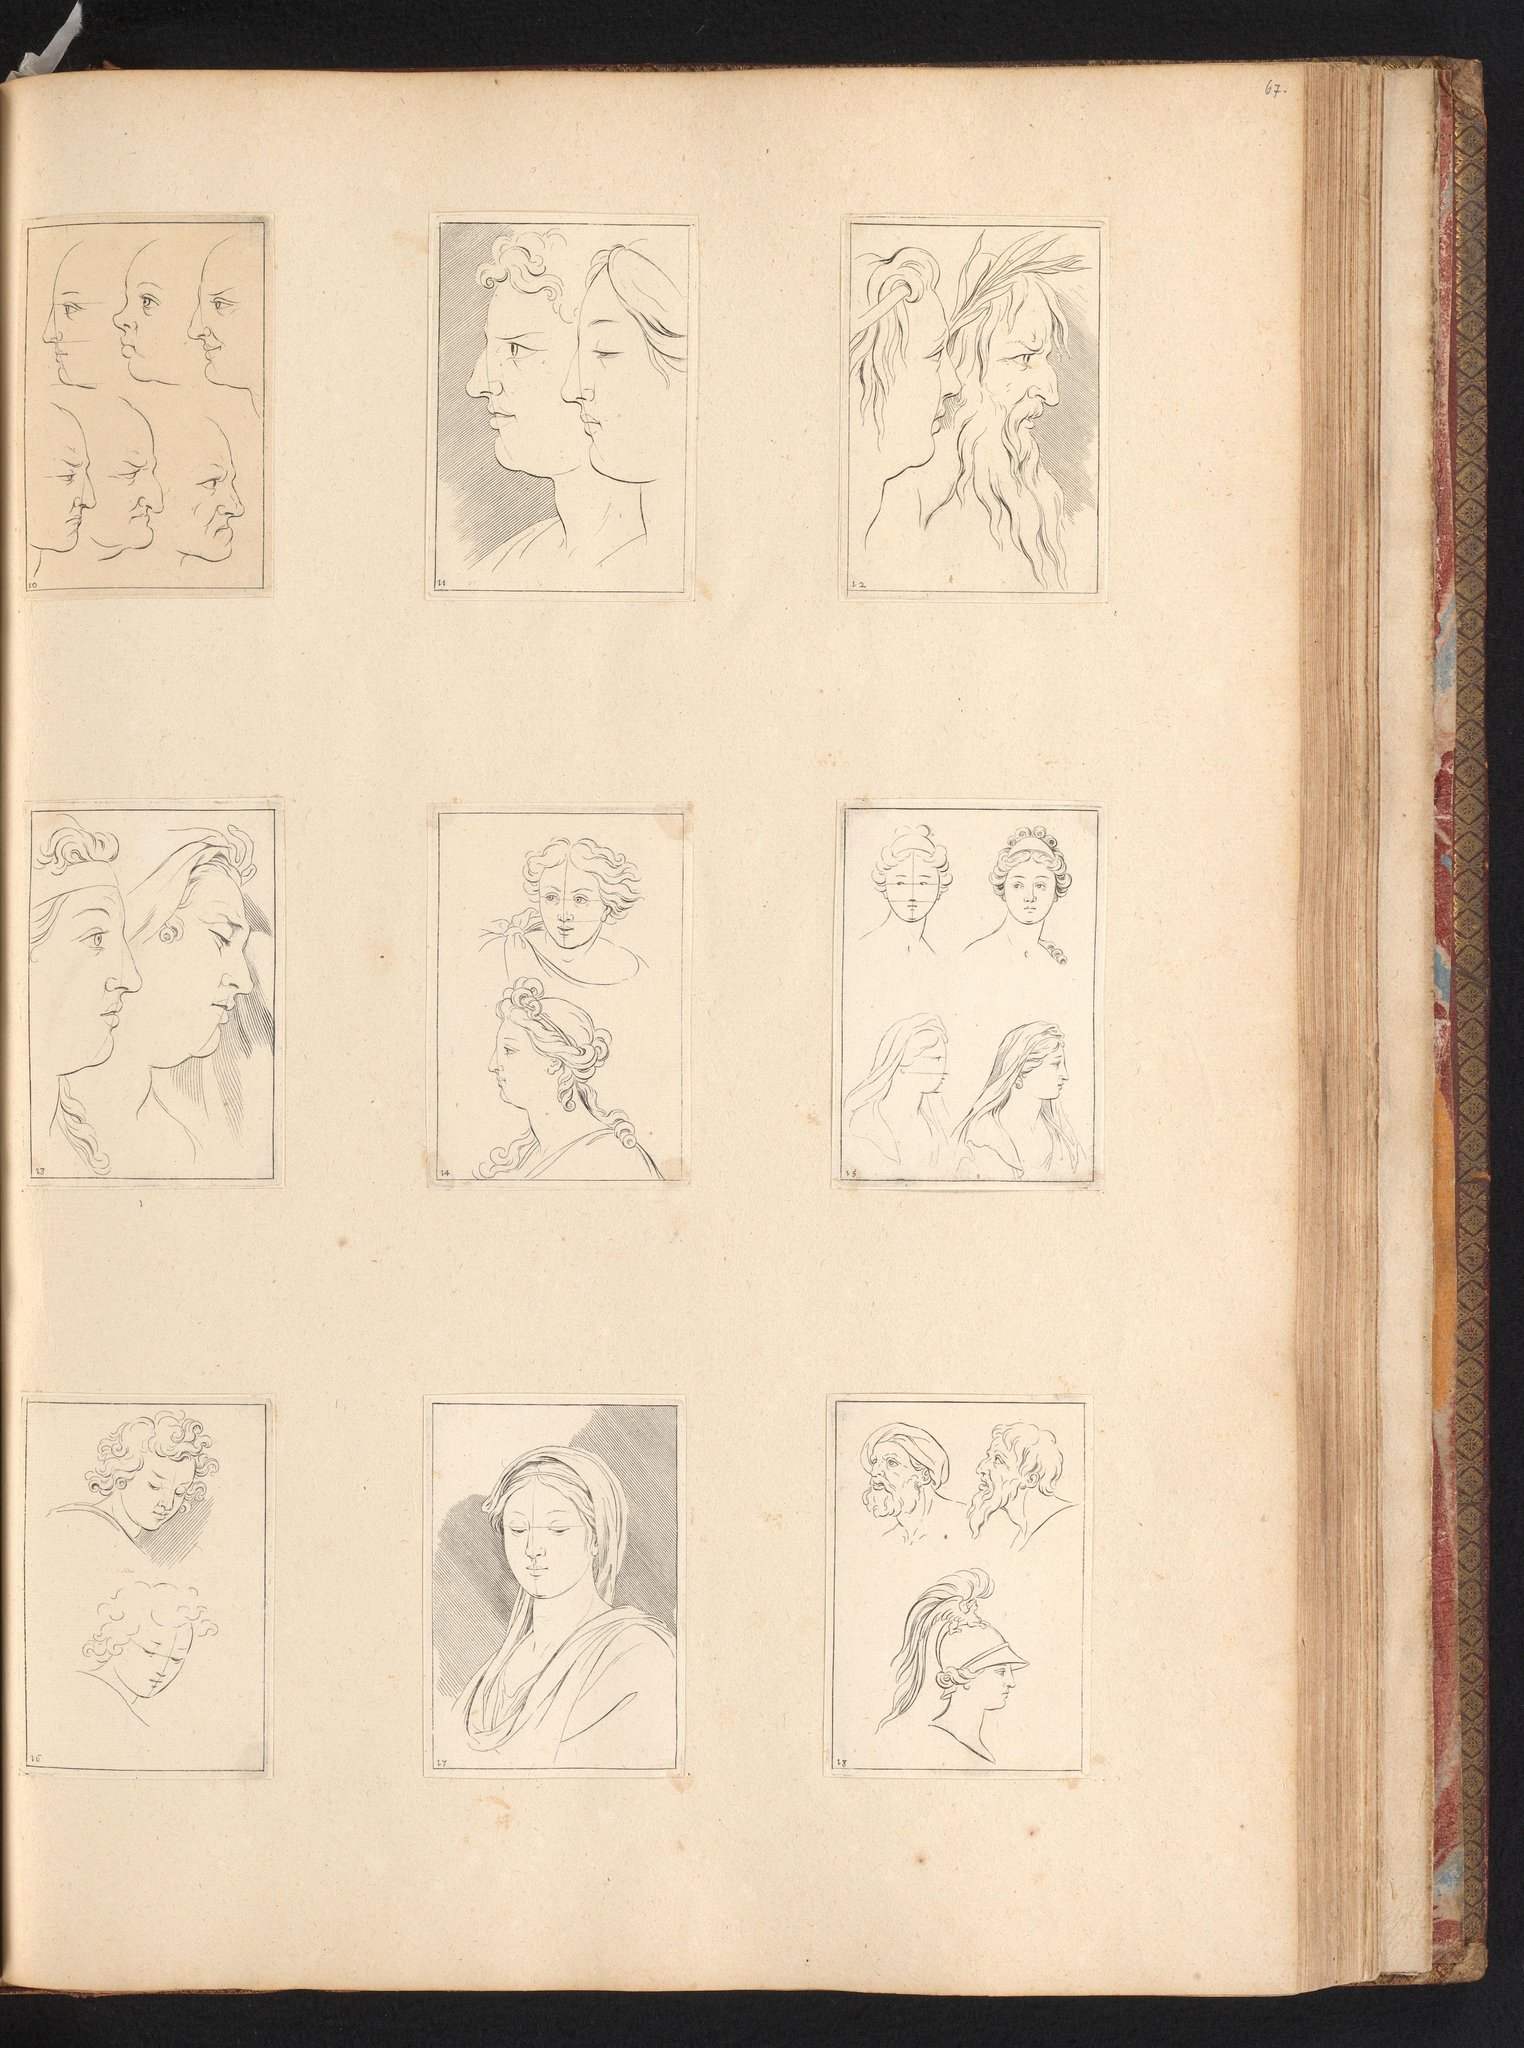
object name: album leaf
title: Negen tekenvoorbeelden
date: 1700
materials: paper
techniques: engraving, etching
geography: france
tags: model-books ~ implements of painter, tools, implements of draughtsman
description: Negen tekenvoorbeelden van hoofden van mannen en vrouwen. Alle negen prenten zijn linksonder genummerd van 10 t/m 18. Deze negen prenten maken deel uit van een album.